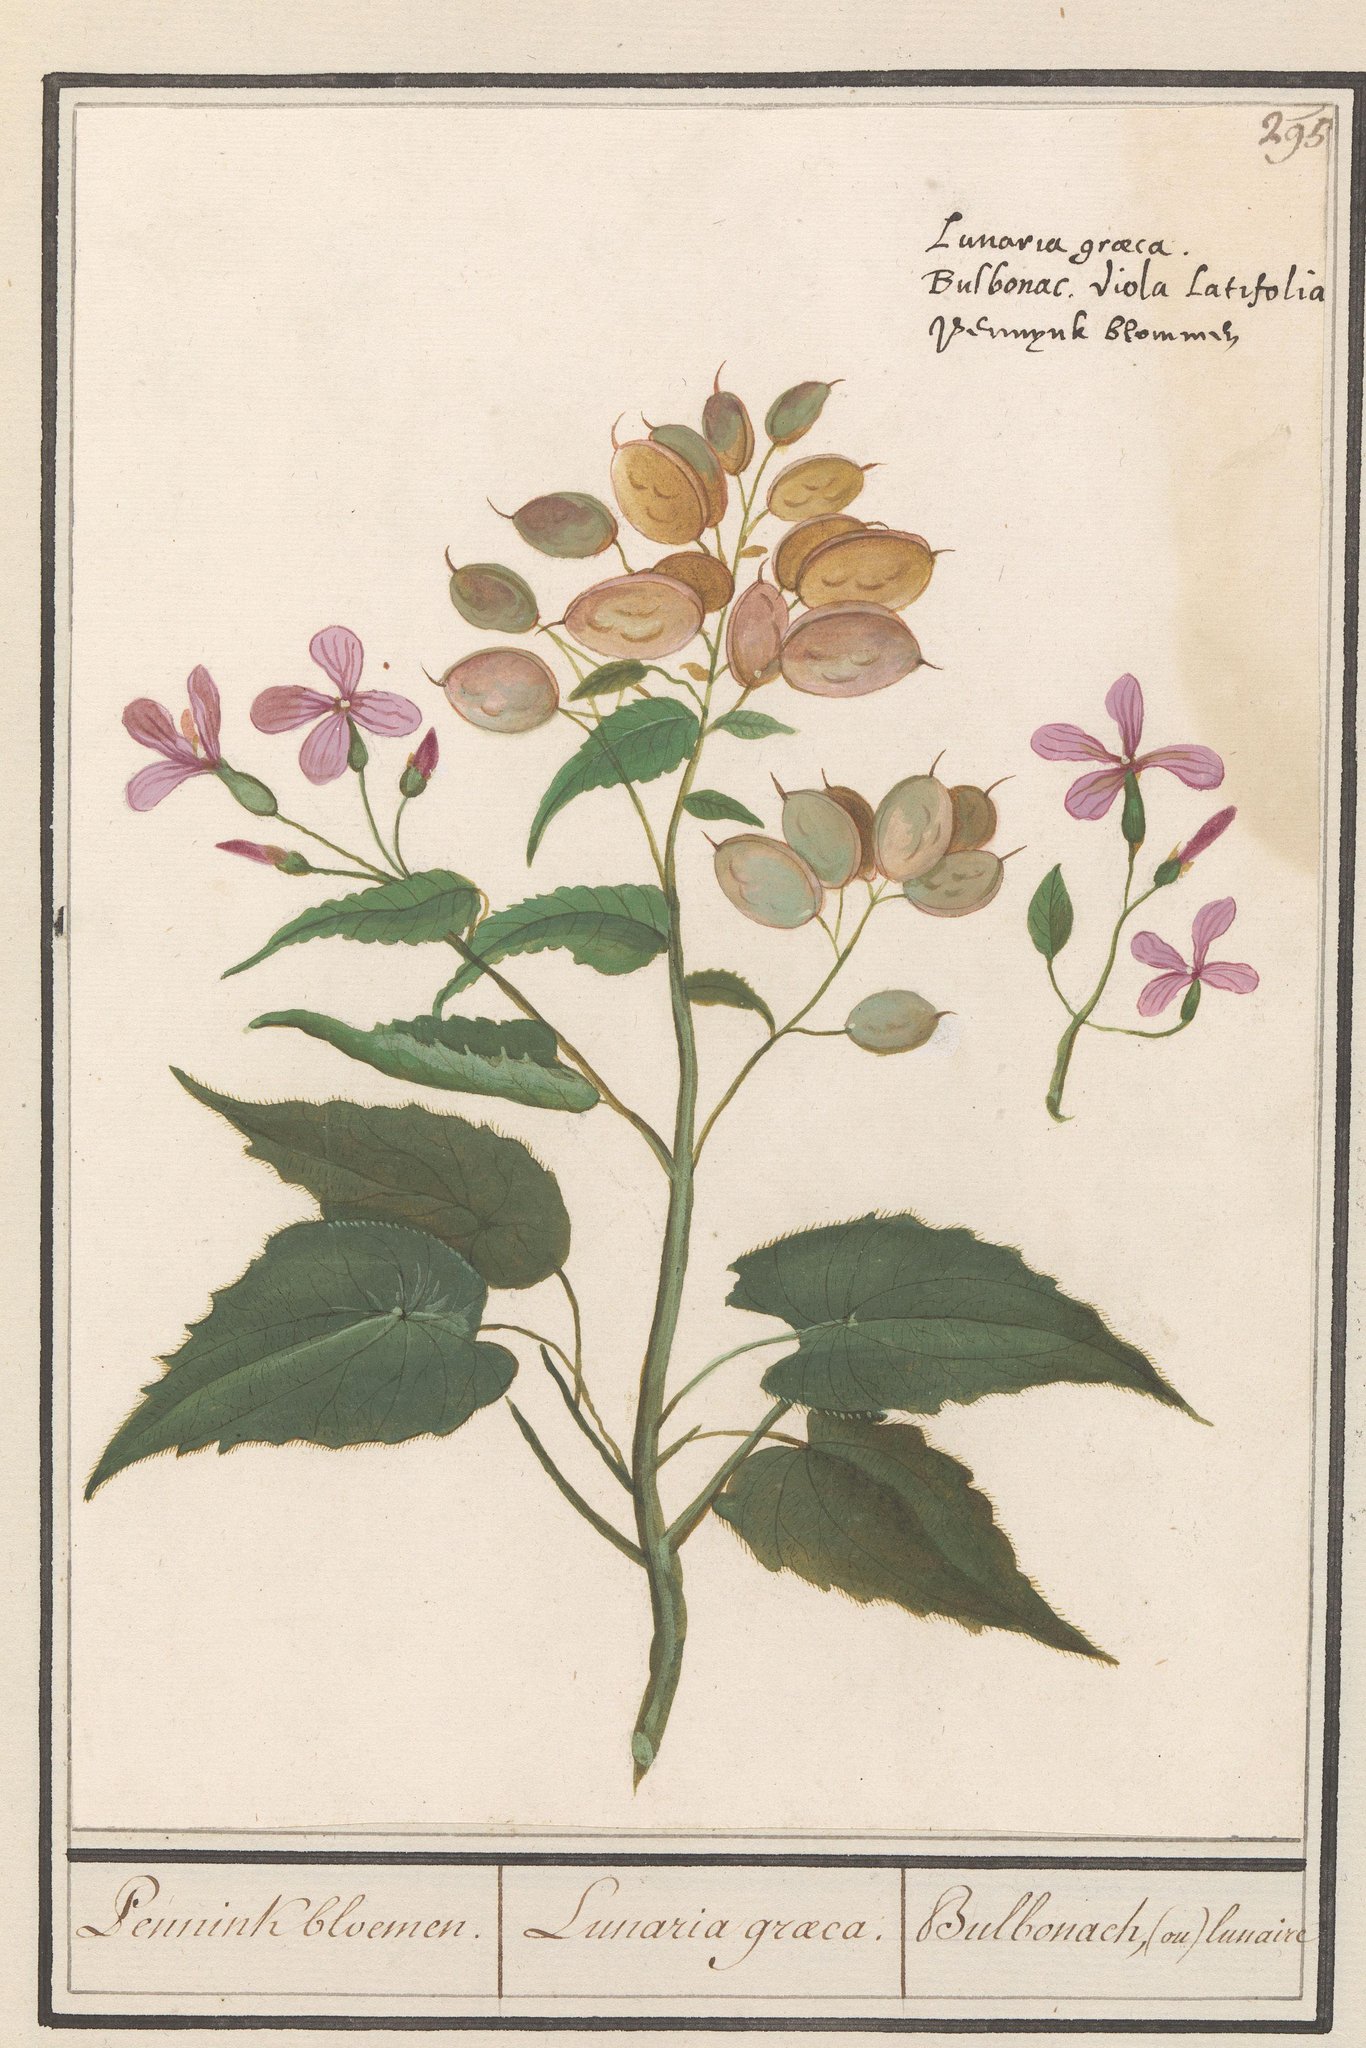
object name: drawing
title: Honesty (Lunaria annua)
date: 1596-1610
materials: chalk, paint, ink, paper, watercolor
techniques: brush, pen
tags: flowers: honesty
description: The honesty plant is immediately recognizable by its distinctive flat, and sometimes translucent, seed pods. In this drawing, the plant also bears flowers, something that never occurs simultaneously in reality. De Boodt wanted to give a generic image of the plant in all of its flowering stages, rather than depict a specific specimen from nature. Thus, the drawing was useful in identifying the species.